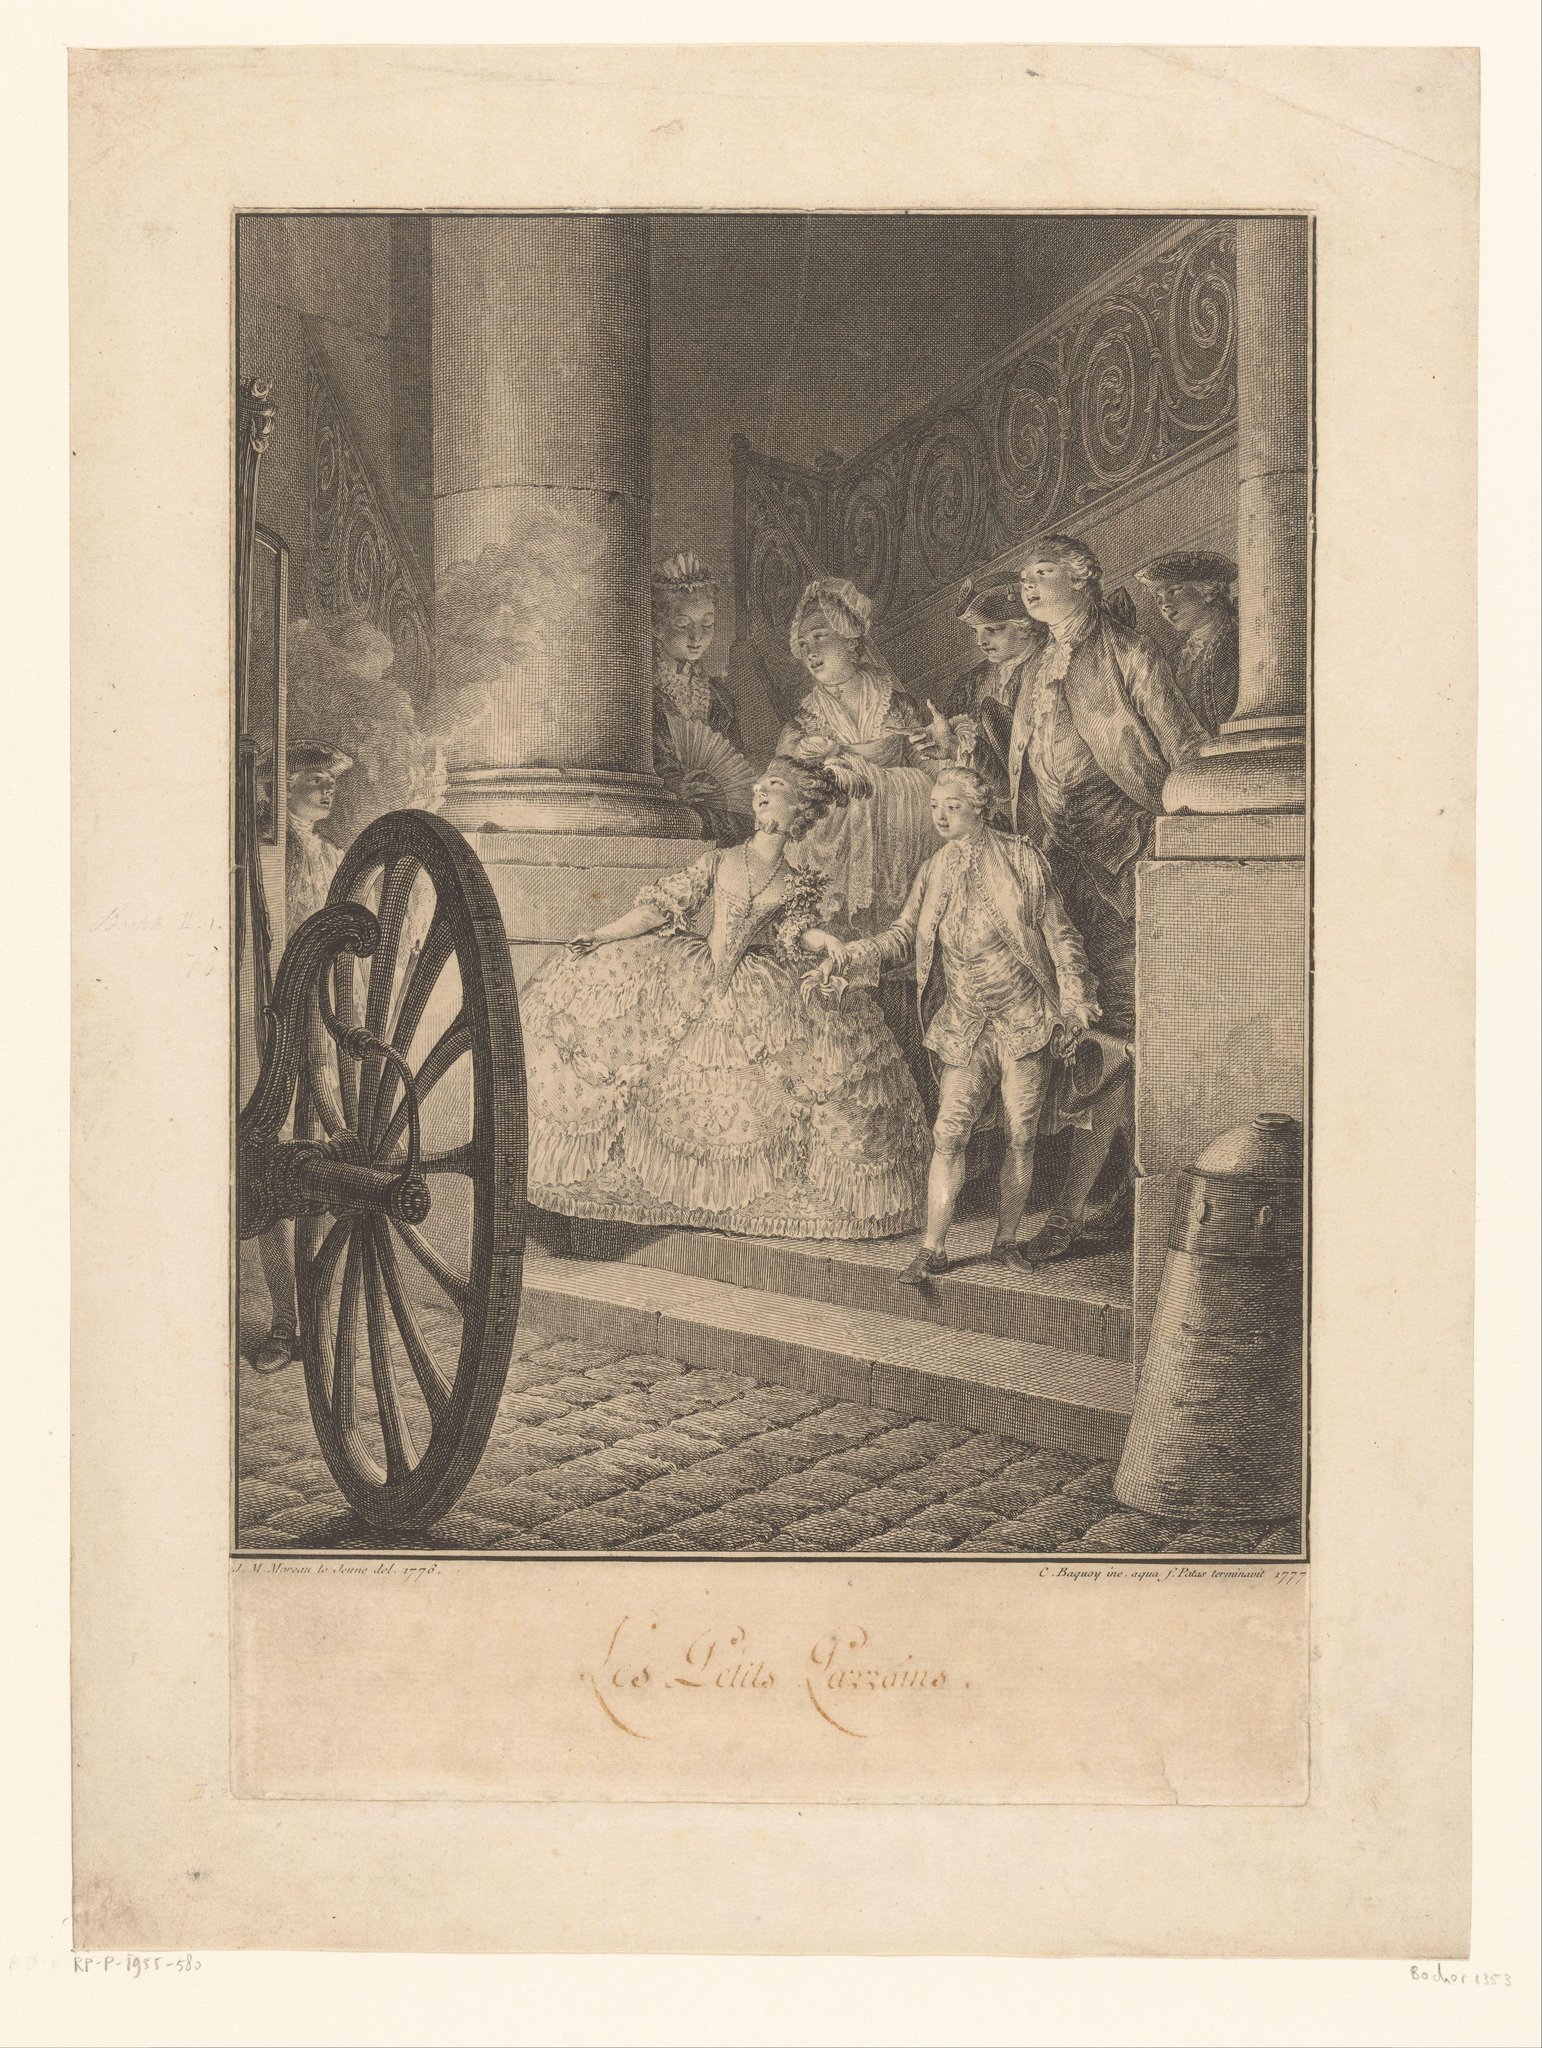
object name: print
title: Jonge peetouders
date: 1777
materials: paper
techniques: engraving, etching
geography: france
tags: family group, especially parents with their child(ren), passenger carriage, godfather and godmother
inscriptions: title: ‘Les Petits Parrains’, collector's mark: Lugt 2228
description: Een latere staat van deze prent behoort tot de reeks 'Le Monument du Costume. Suite d'estampes pour servir à l'histoire des moeurs et du costume français dans le dix-huitième siècle'.